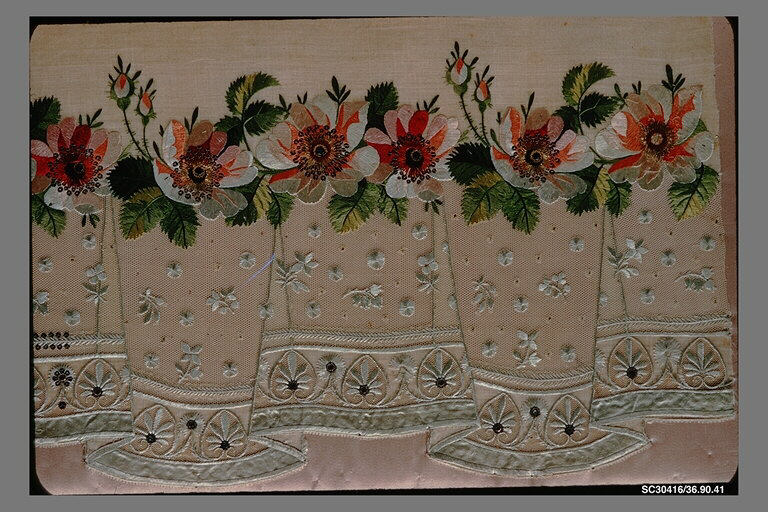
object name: border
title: Dress border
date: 1801-1833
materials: cotton, metal thread, silk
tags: flowers